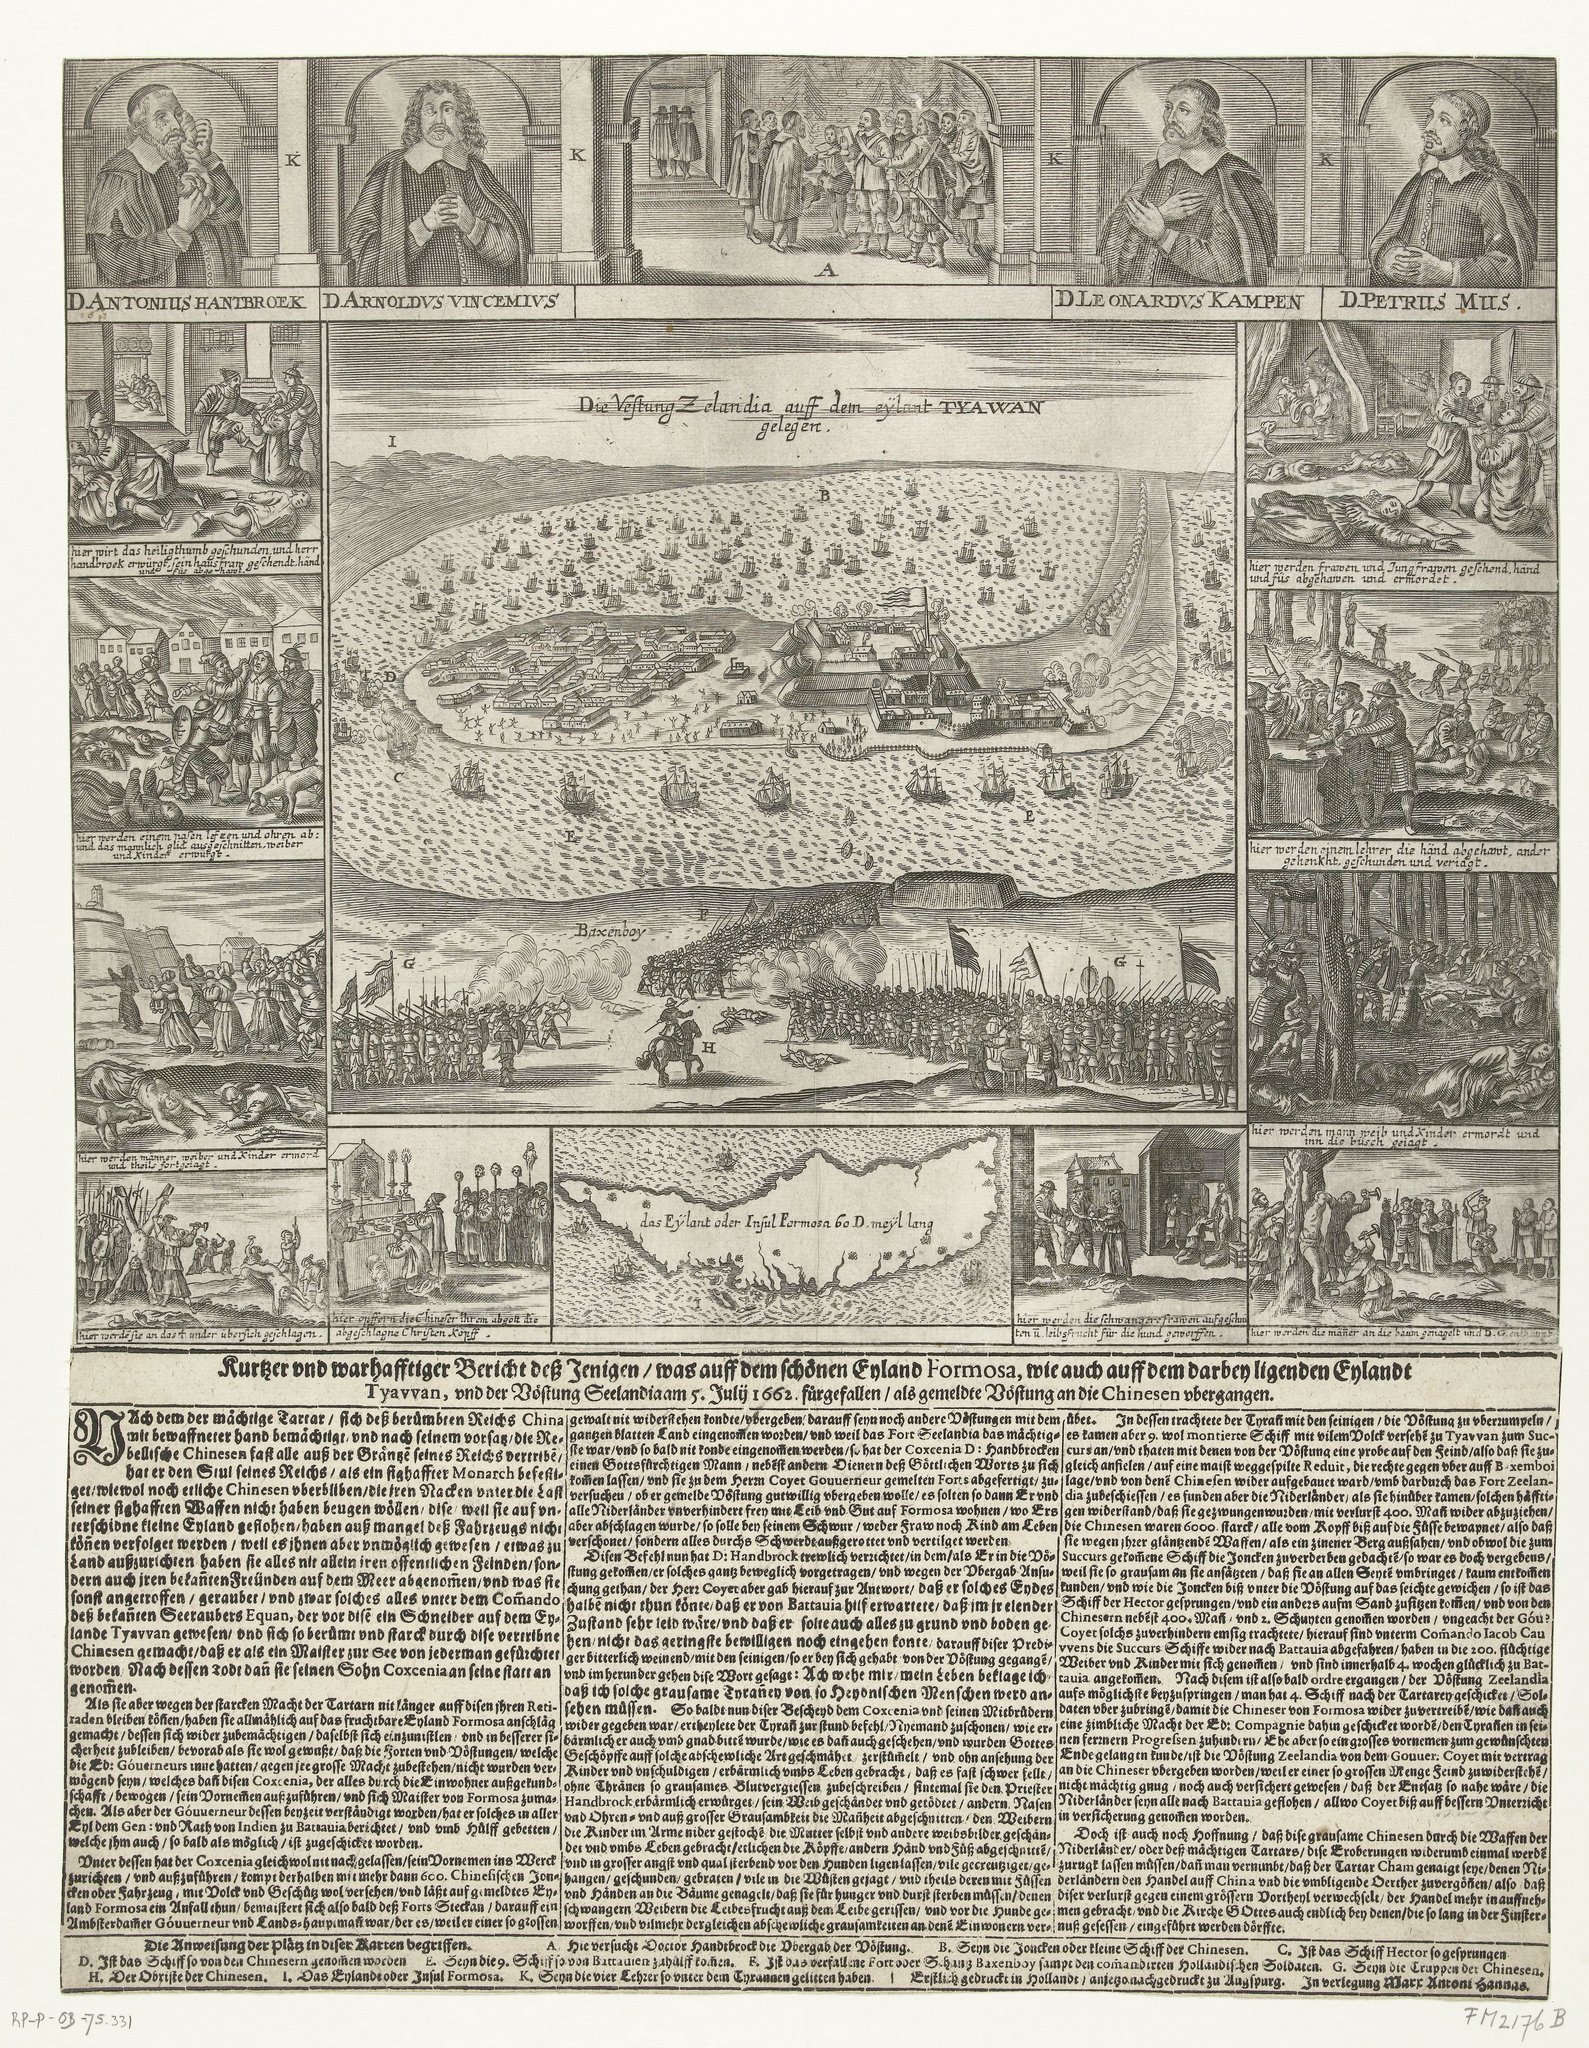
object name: print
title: Verovering van Fort Zeelandia op Formosa door de Chinezen en de marteling en moord op de gereformeerde predikanten, 1661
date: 1663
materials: paper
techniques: etching, letterpress printing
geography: northern netherlands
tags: formosa, capture of city (after the siege), torture, violent death, being killed; being mishandled and maltreated; seeking death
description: Verovering van Fort Zeelandia op Formosa door de Chinezen en de marteling en moord op de gereformeerde predikanten. Vier gereformeerde predikanten en een ziekentrooster gevangengenomen, gemarteld en vermoord op Formosa door de Chinese zeerover Coxinga, 5 juli en oktober 1661. Bovenaan de portretten van de vier predikanten Antonius Hambroeck, Arnoldus Vincemius, Petrus Muts en Leonardus van Campen. In het midden brengt Hambroeck met verzoek om overgave van het fort over. Centraal een gezicht op de gevechten rond het fort Zeelandia. Hieromheen tien kleine voorstellingen van de wreedheden. Onder het blad is geplakt een tekst gedrukt in 3 kolommen met de legenda A-K.